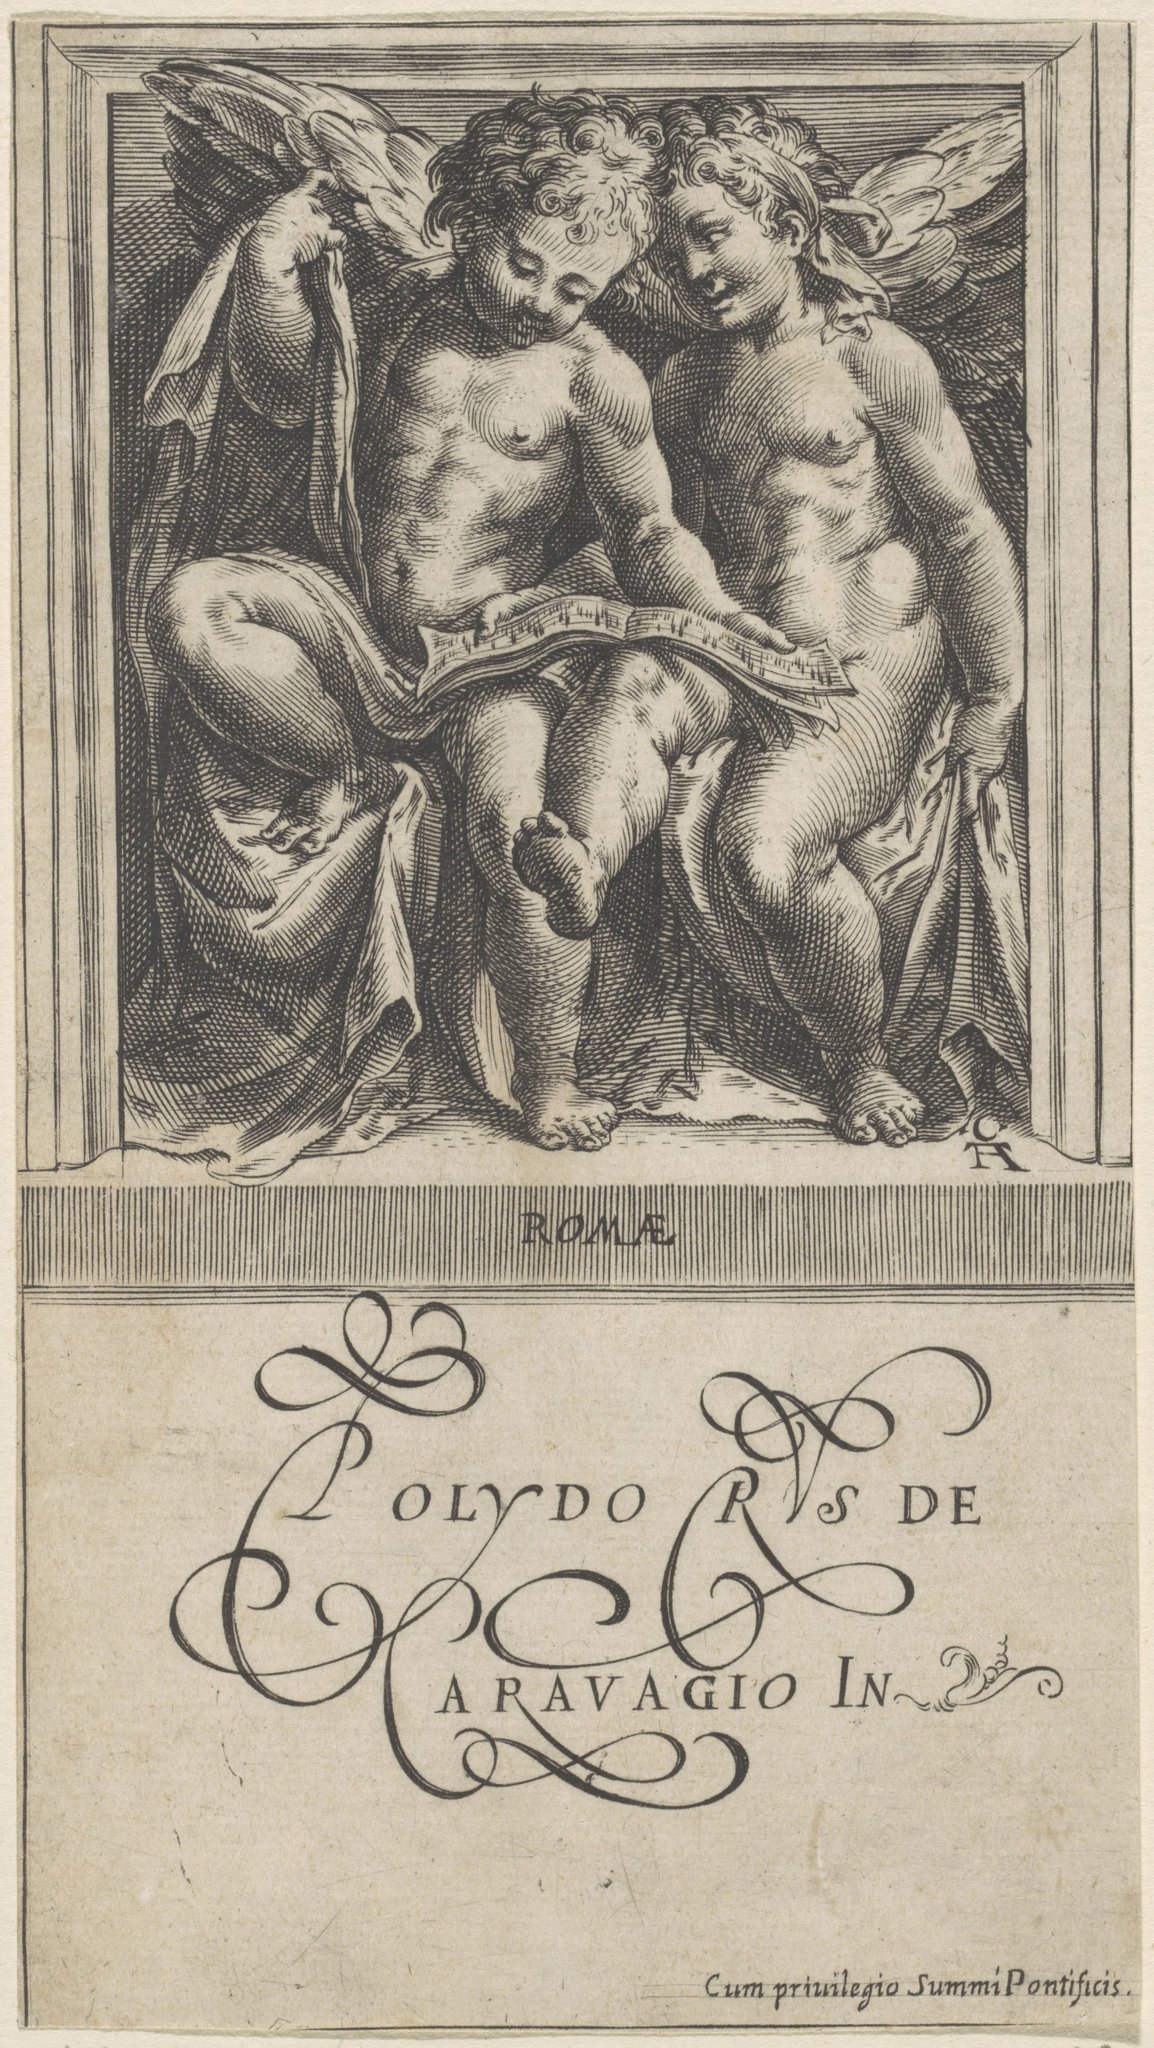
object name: print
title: Concert van de engelen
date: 1563-1615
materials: paper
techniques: engraving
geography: rome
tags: angels singing, making music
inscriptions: collector's mark: Lugt 240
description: Twee zingende engelen. De ene engel kijkt naar de andere engel. Op hun schoot een boek met bladmuziek. In de ondermarge de naam van de ontwerper in sierletters.